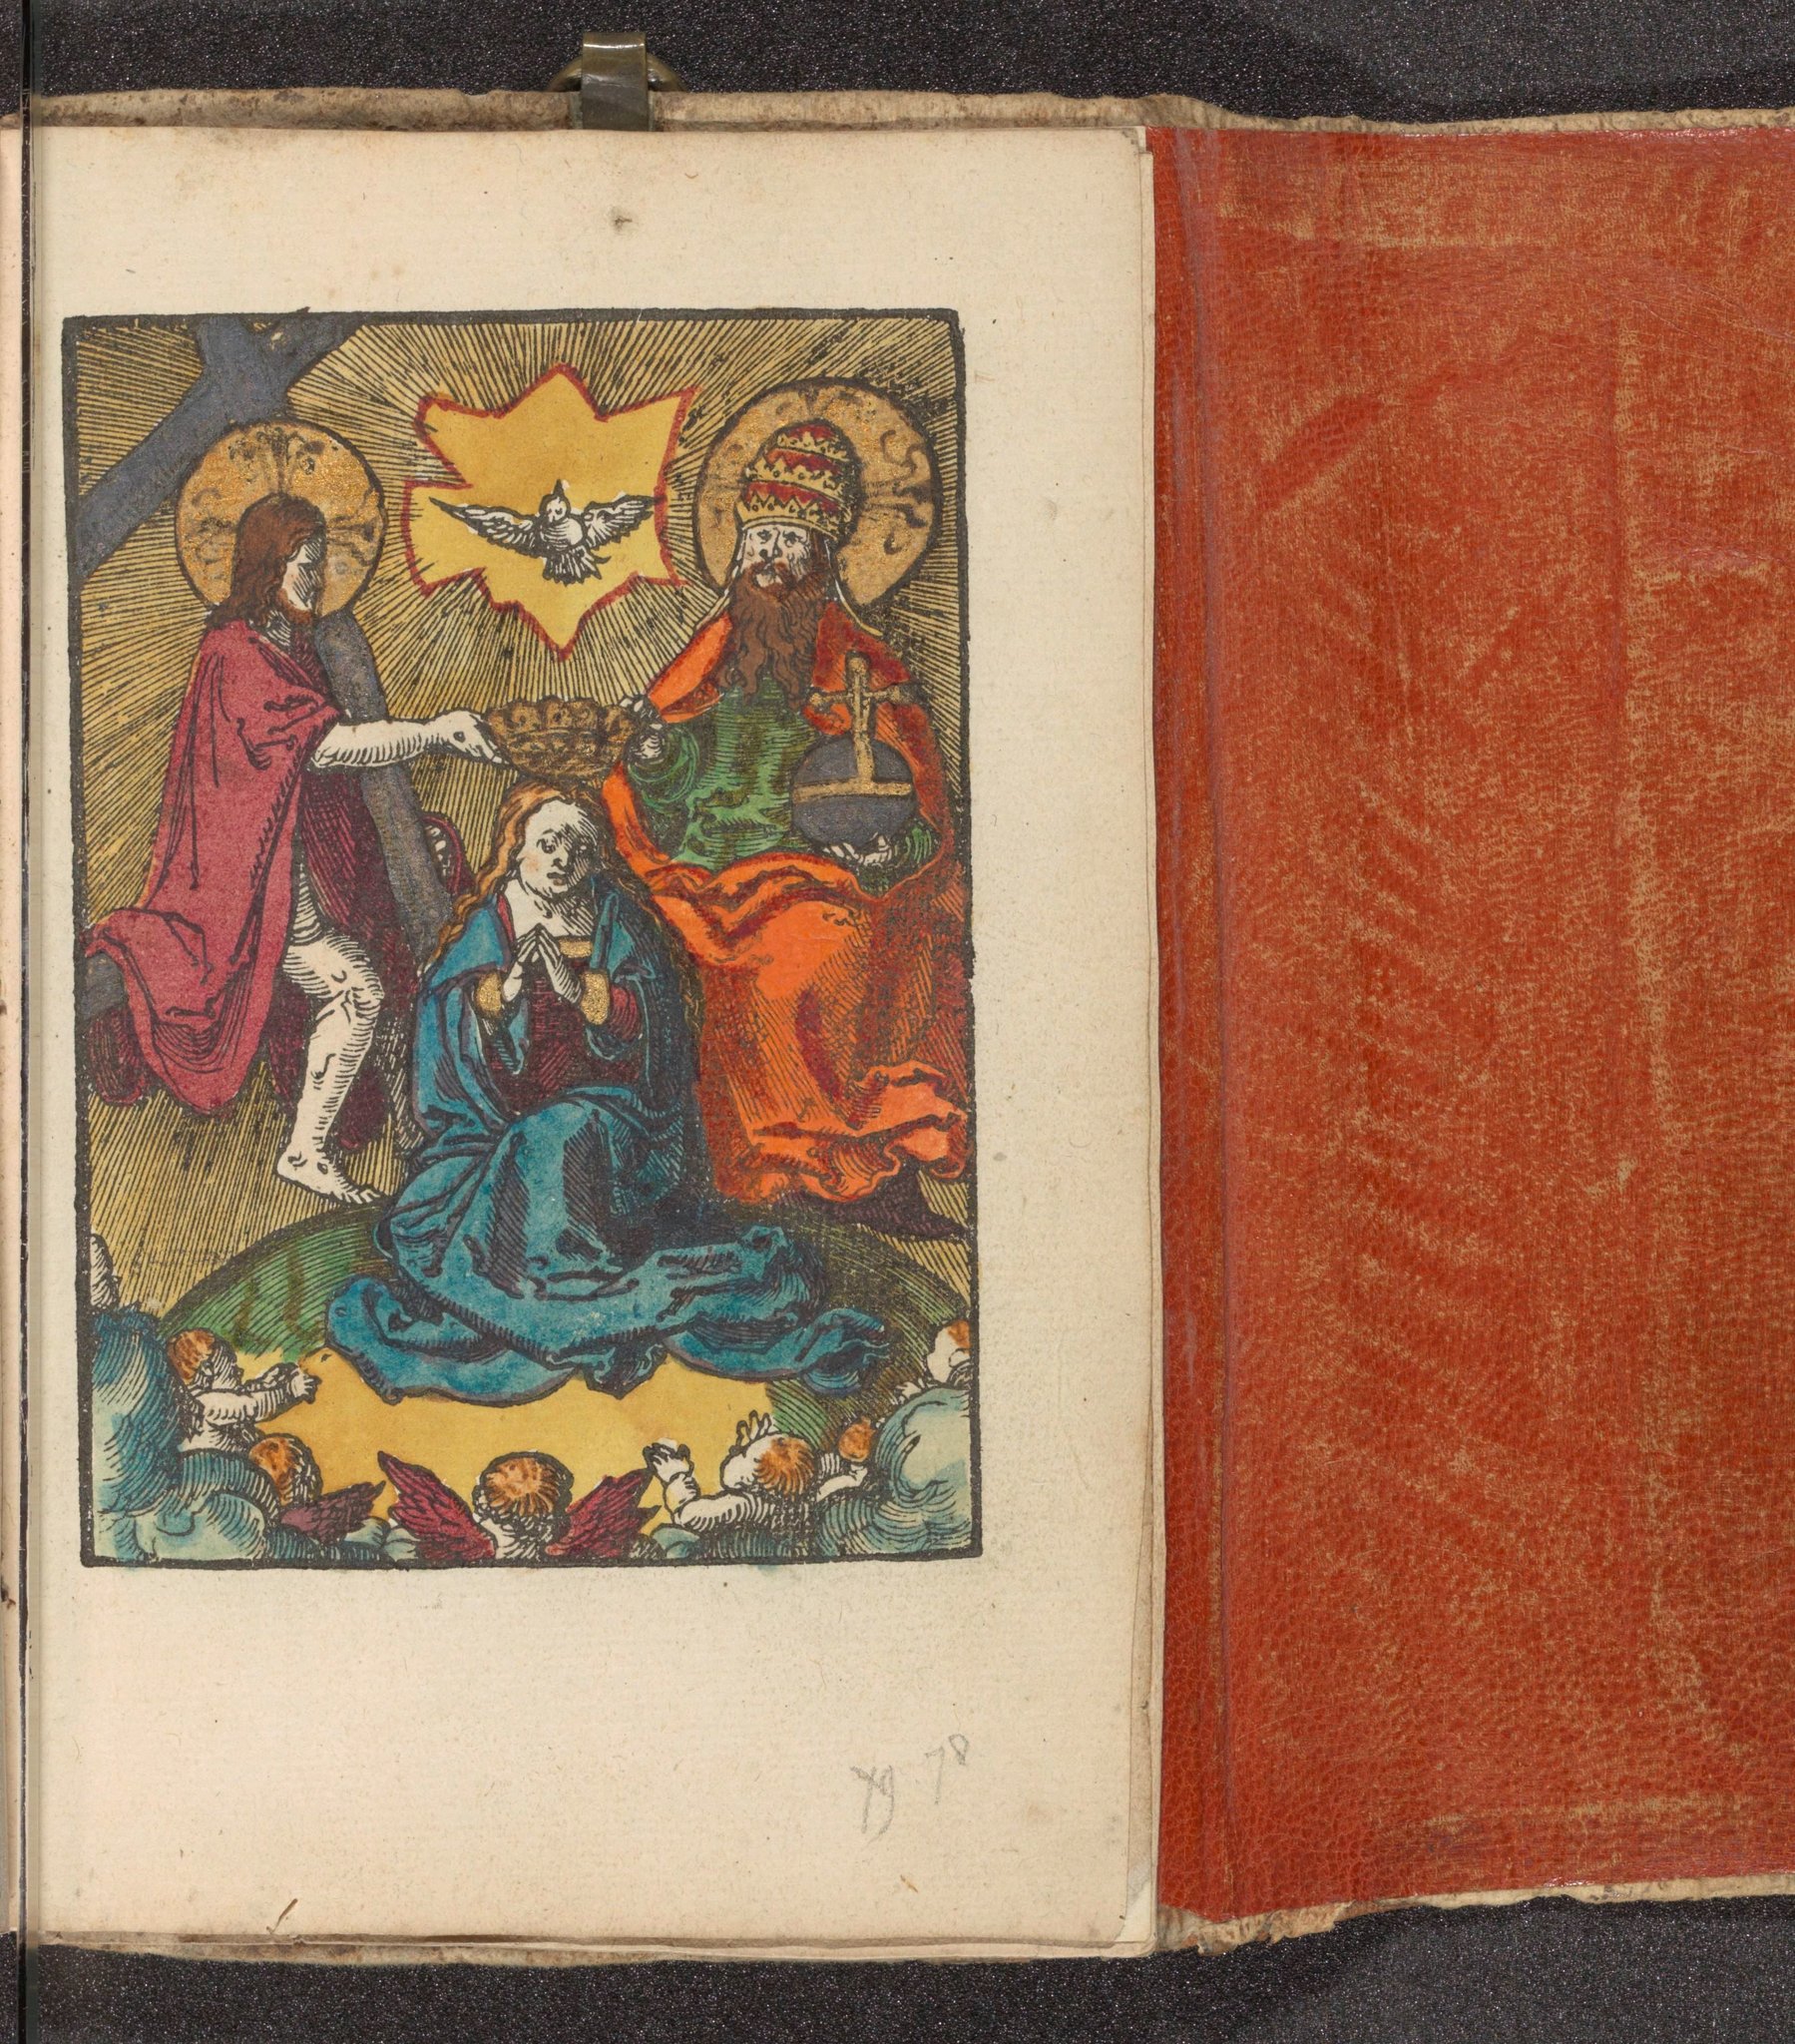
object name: print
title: Stomme Passie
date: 1530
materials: paper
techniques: hand coloring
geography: low countries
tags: coronation of mary in heaven (usually the holy trinity present), book in which illustrations are essential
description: Christus en God de Vader kronen Maria. Daarboven zweeft de Heilige Geest. Prent maakt deel uit van een boek.